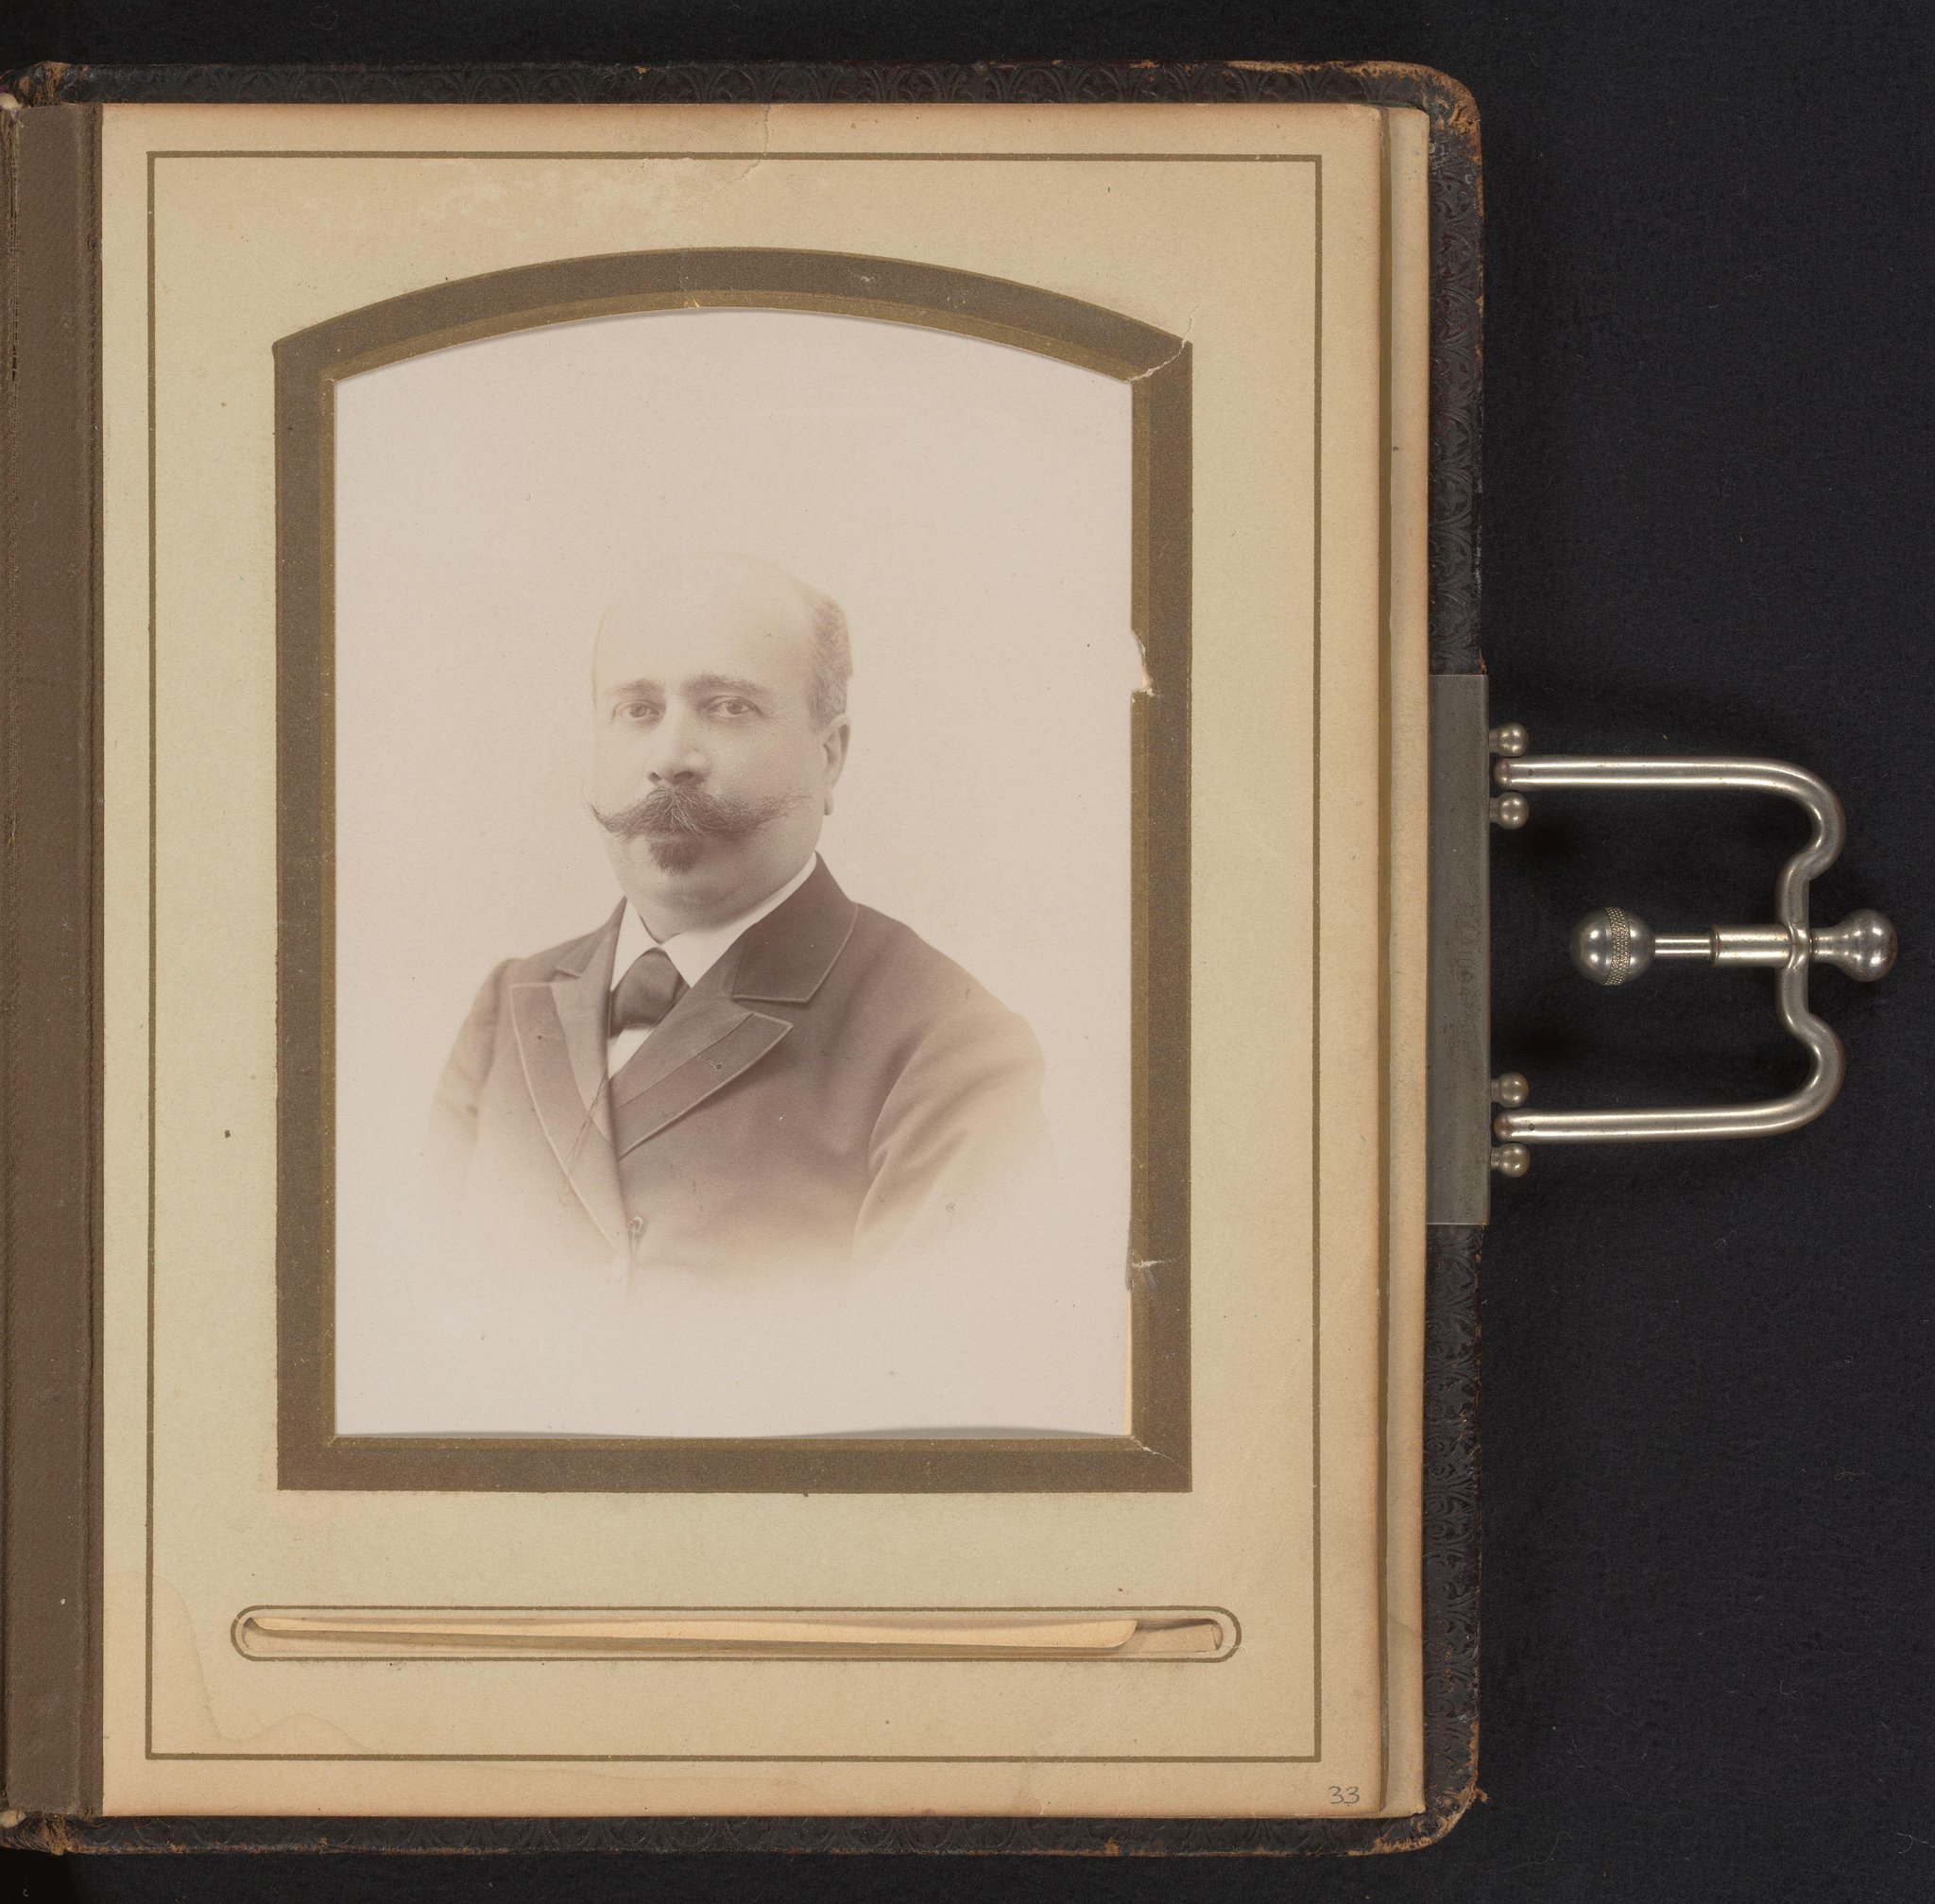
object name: photograph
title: Portret van een man met snor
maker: berger (fotograaf)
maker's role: fotograaf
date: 1880-1940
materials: cardboard, photographic support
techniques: collodion silver print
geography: france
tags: moustache, historical persons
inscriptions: inscription: ‘BERGER/ PHOTOGRAPHE/ 112, RUE DE COURCELLES/ Paris-Levallois/ Le Tramway Levallois qui part de la Madeleine/ passe devant la porte/ Hôtel Privé’